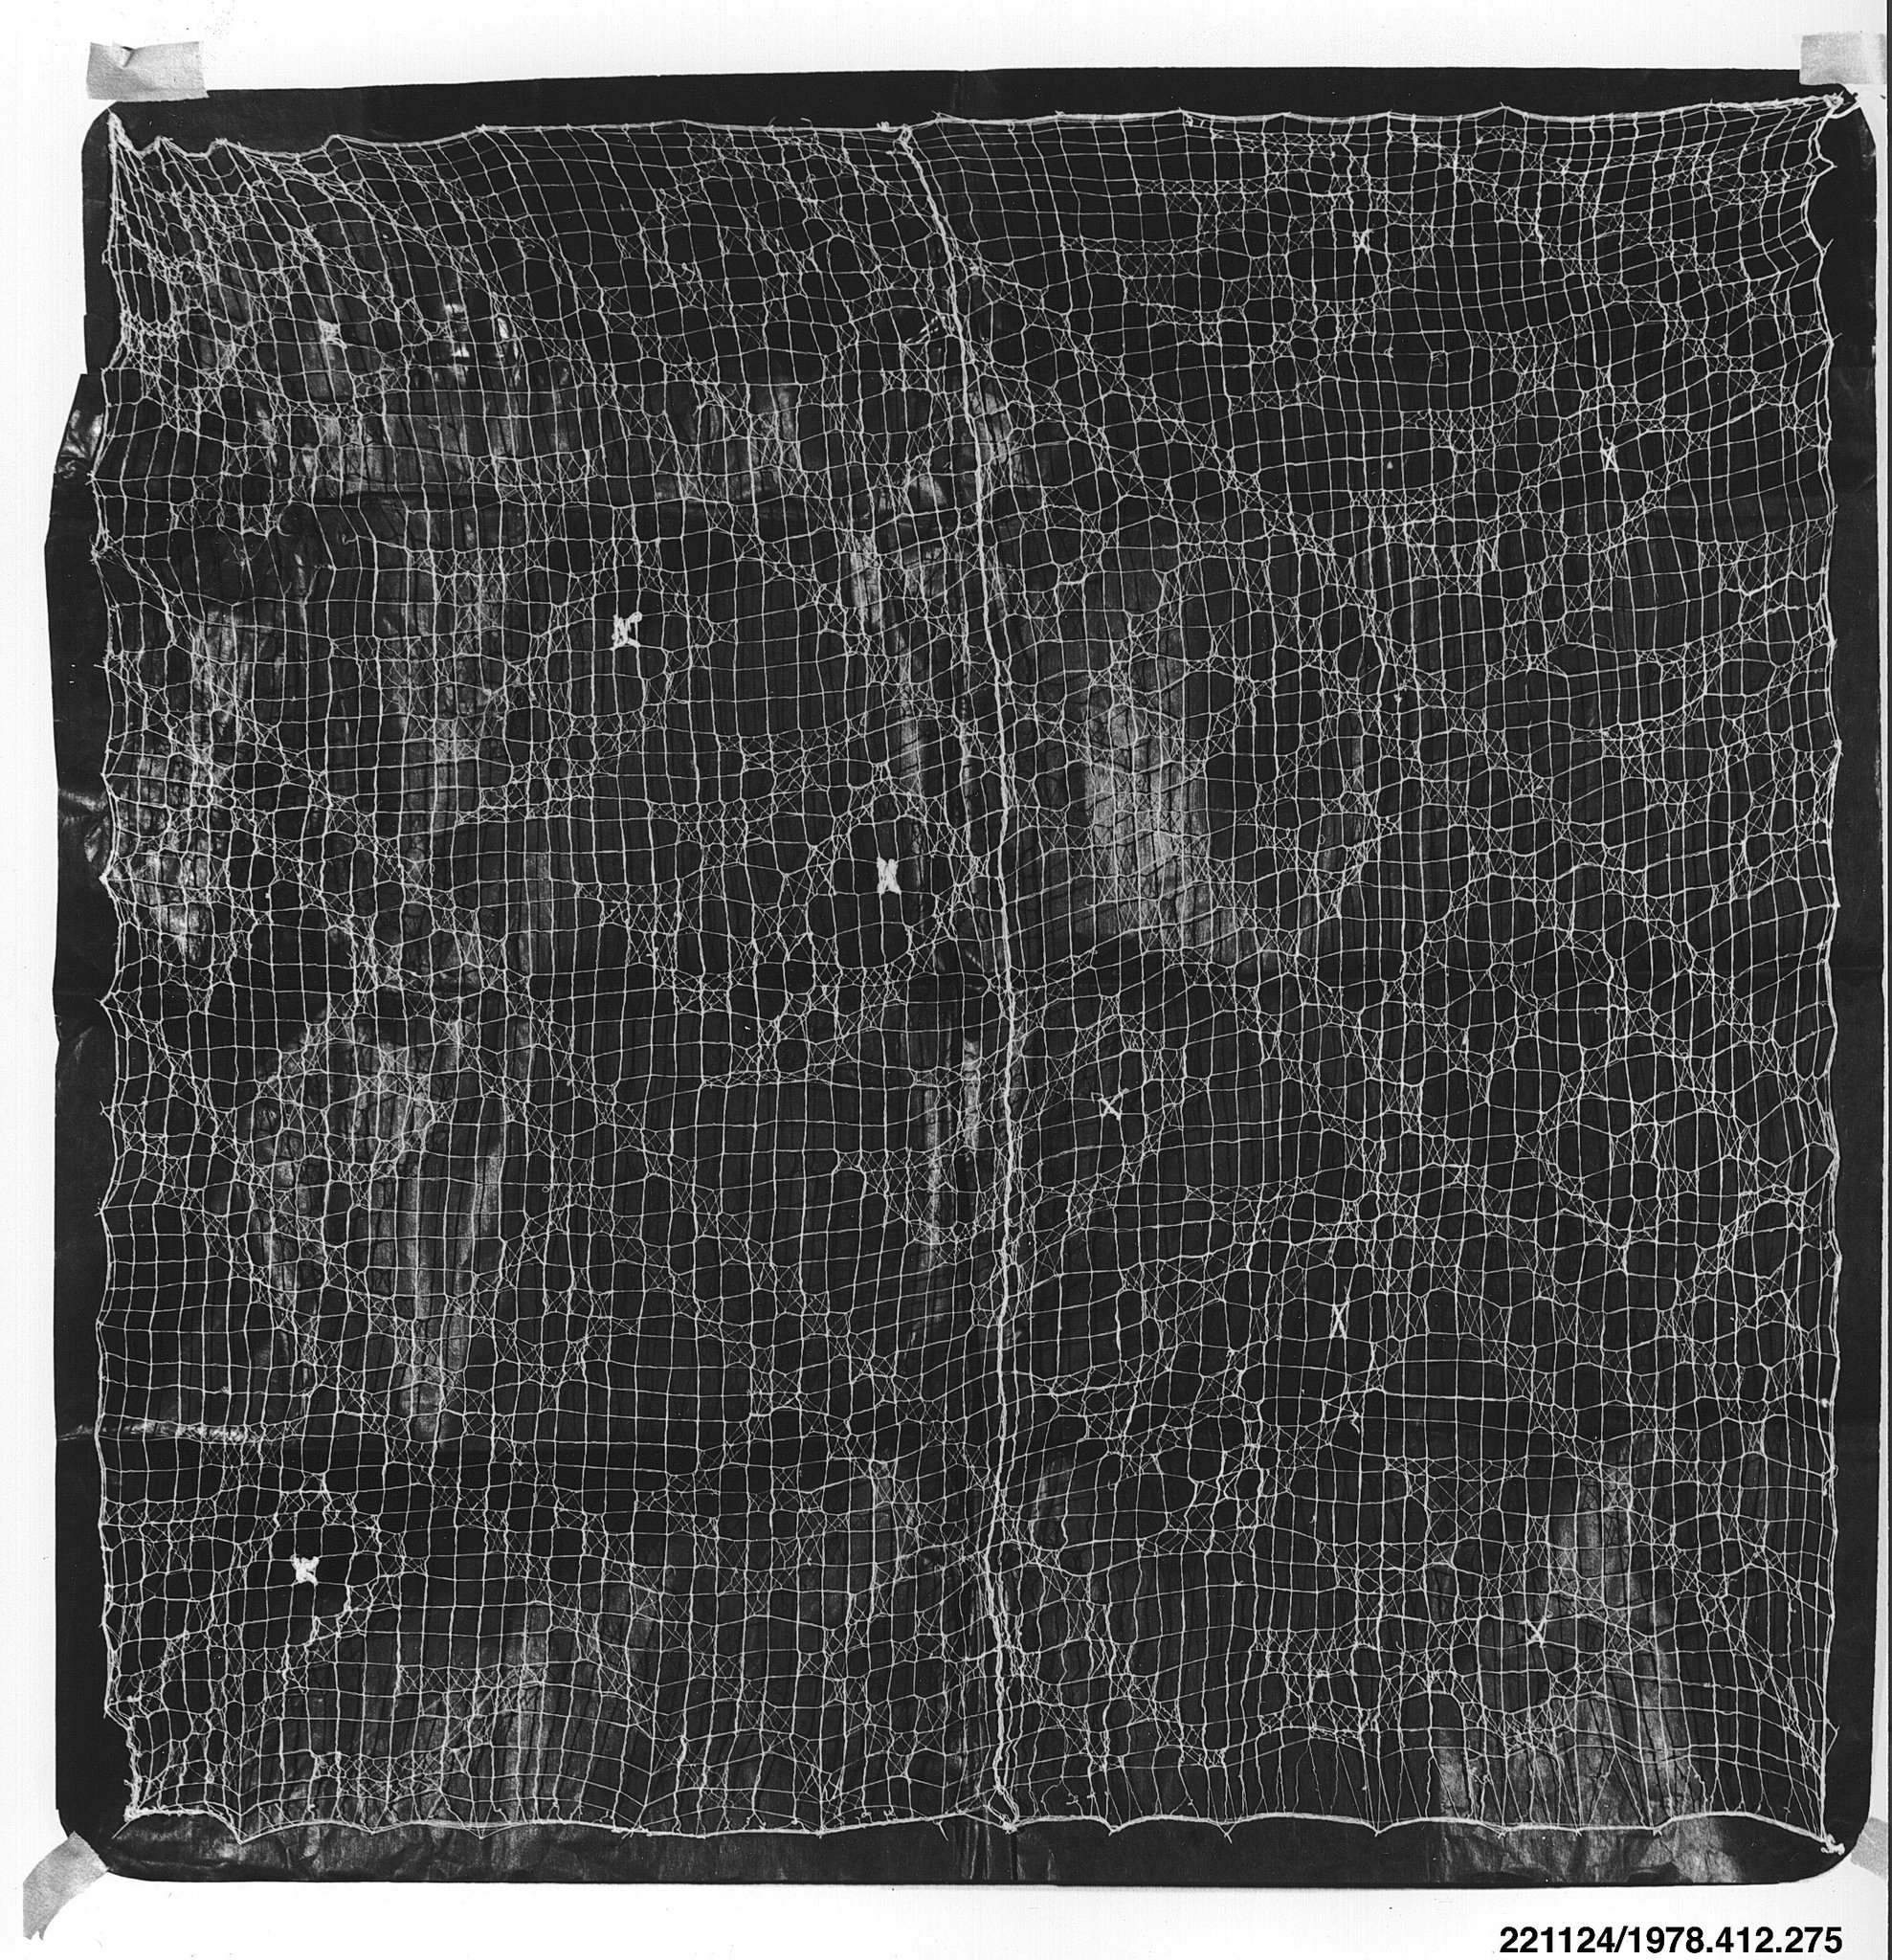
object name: headband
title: Openwork Headband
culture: chancay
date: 1101-1500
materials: cotton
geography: peru